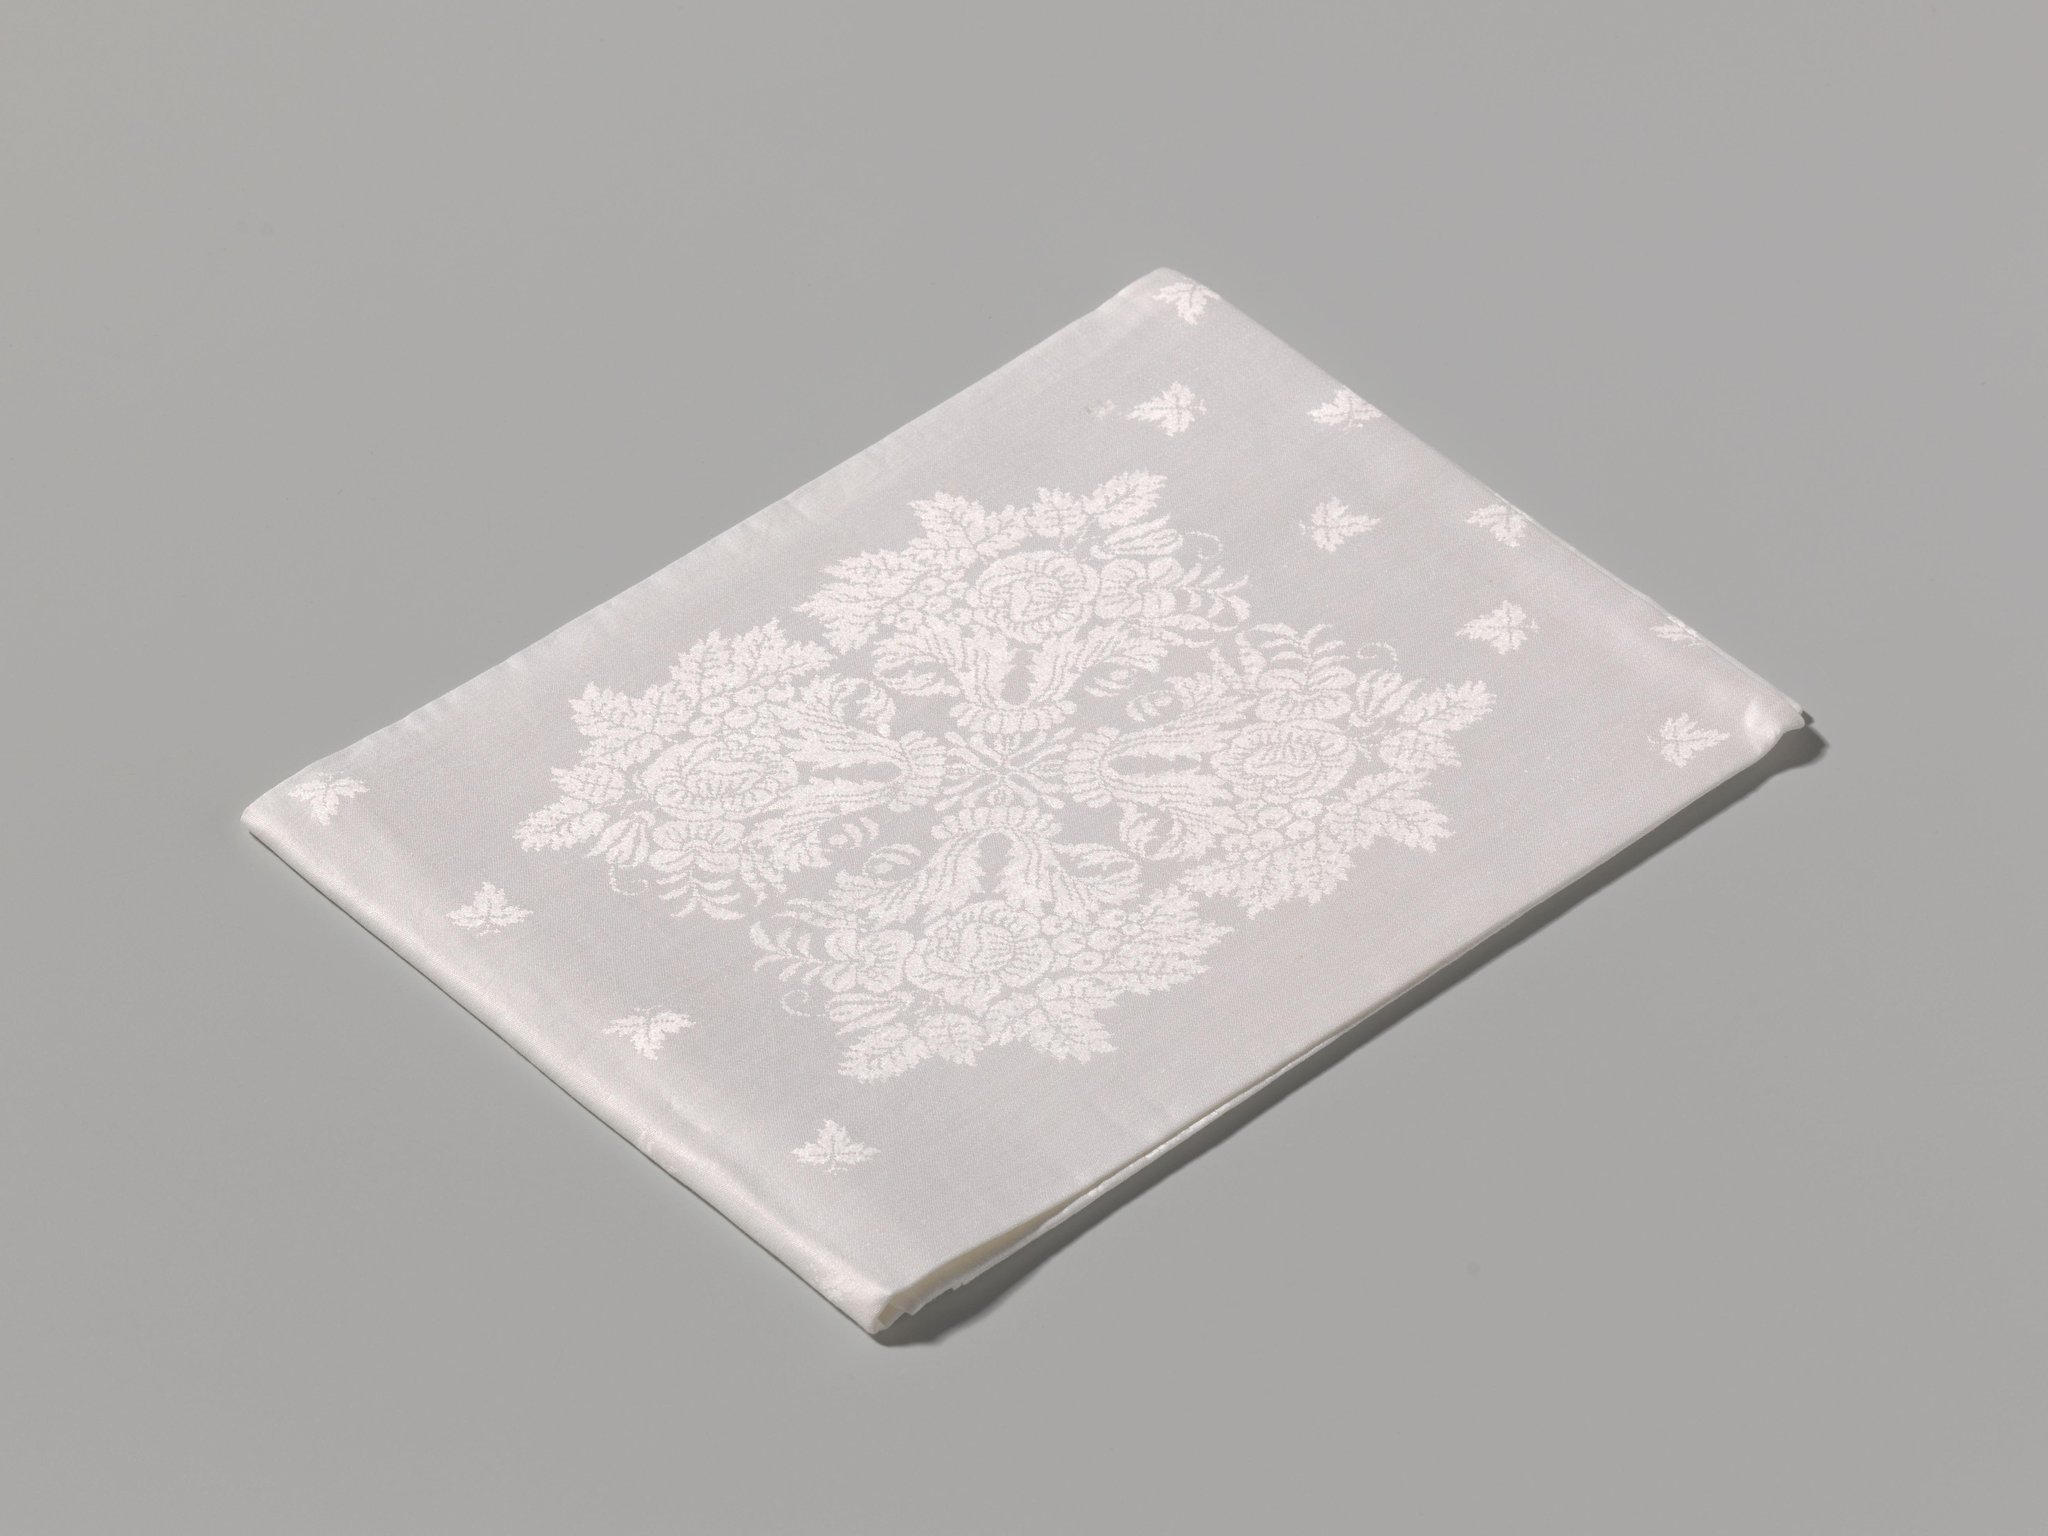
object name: napkin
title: Servet met herme, god en leeuwen te midden van acanthusbladeren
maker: Anonymous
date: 1850-1899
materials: linen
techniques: damask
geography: north brabant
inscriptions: label: ‘R.M. A'dam’, mark: ‘GH 18’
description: Servet van linnendamast met herme, god, leeuwen te midden van acanthusbladeren. Middenveld: Vierpassen van bloemboeketten met roos en gestrooid bladwerk. In de niet omgrensde vierpassen staan de telkens op twee acanthusvoluten geplaatste boeketten overhoeks. Hoeken: overhoeks geplaatst een herme met Midas-kop (of ezelskop?), met muziekinstrumenten en thyrsusstaven. Links en rechts een toegewende leeuw, in toom gehouden door een gevleugelde jonge God (Apollo?) in draperie gehuld. Randen: zonder scheidingslijn is het veld omgeven door een brede rand van symmetrische acanthusranken. Beurtelings dragen de diep ingesneden, gevederde bladvoluten een vruchten- en bloemenmand, of zij staan in twee toegewende spiraalvormen, die in een ramsmasker eindigen, boven twee bloemtakken en een pijnappel.